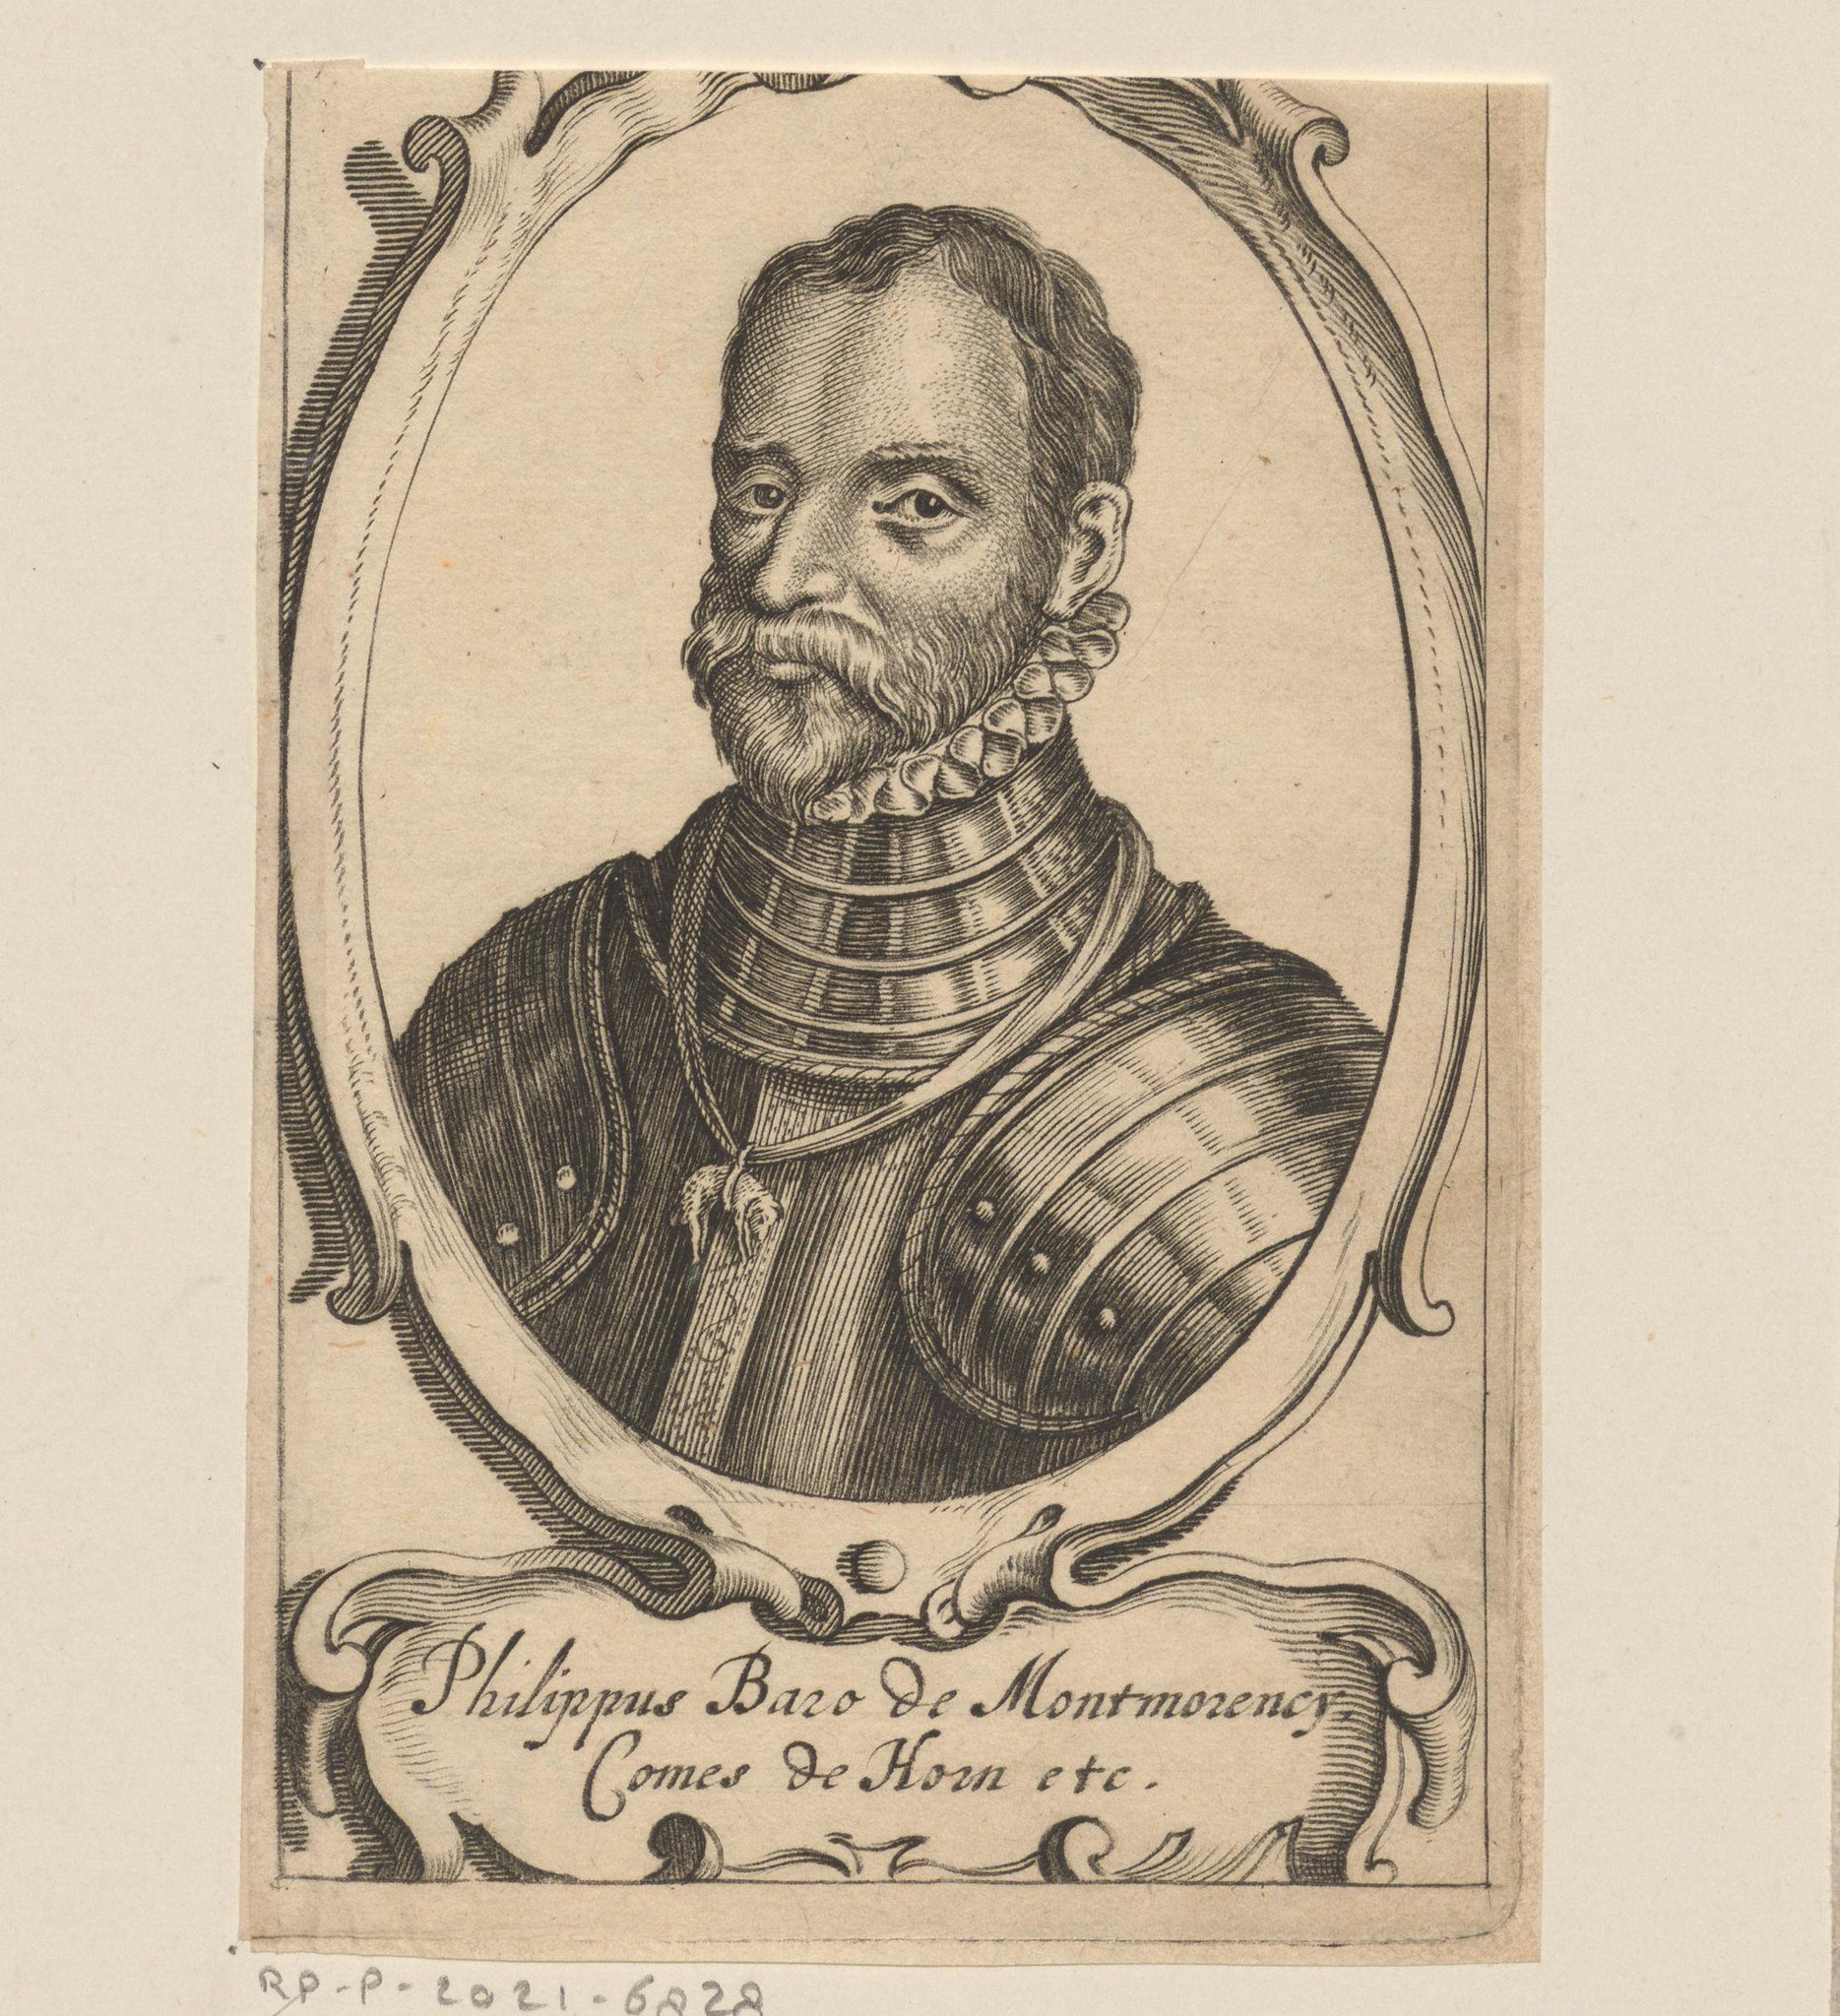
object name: print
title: Portret van Filips van Montmorency, graaf van Horne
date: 1660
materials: paper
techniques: engraving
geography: amsterdam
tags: brussels, armour, historical persons, knighthood order of the golden fleece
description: Prent uit: Bos, Lambert van den. Het vorstelick treurtoonneel, of op- en onder-gang der grooten. Amsterdam: Abraham Wolfgang, 1660.